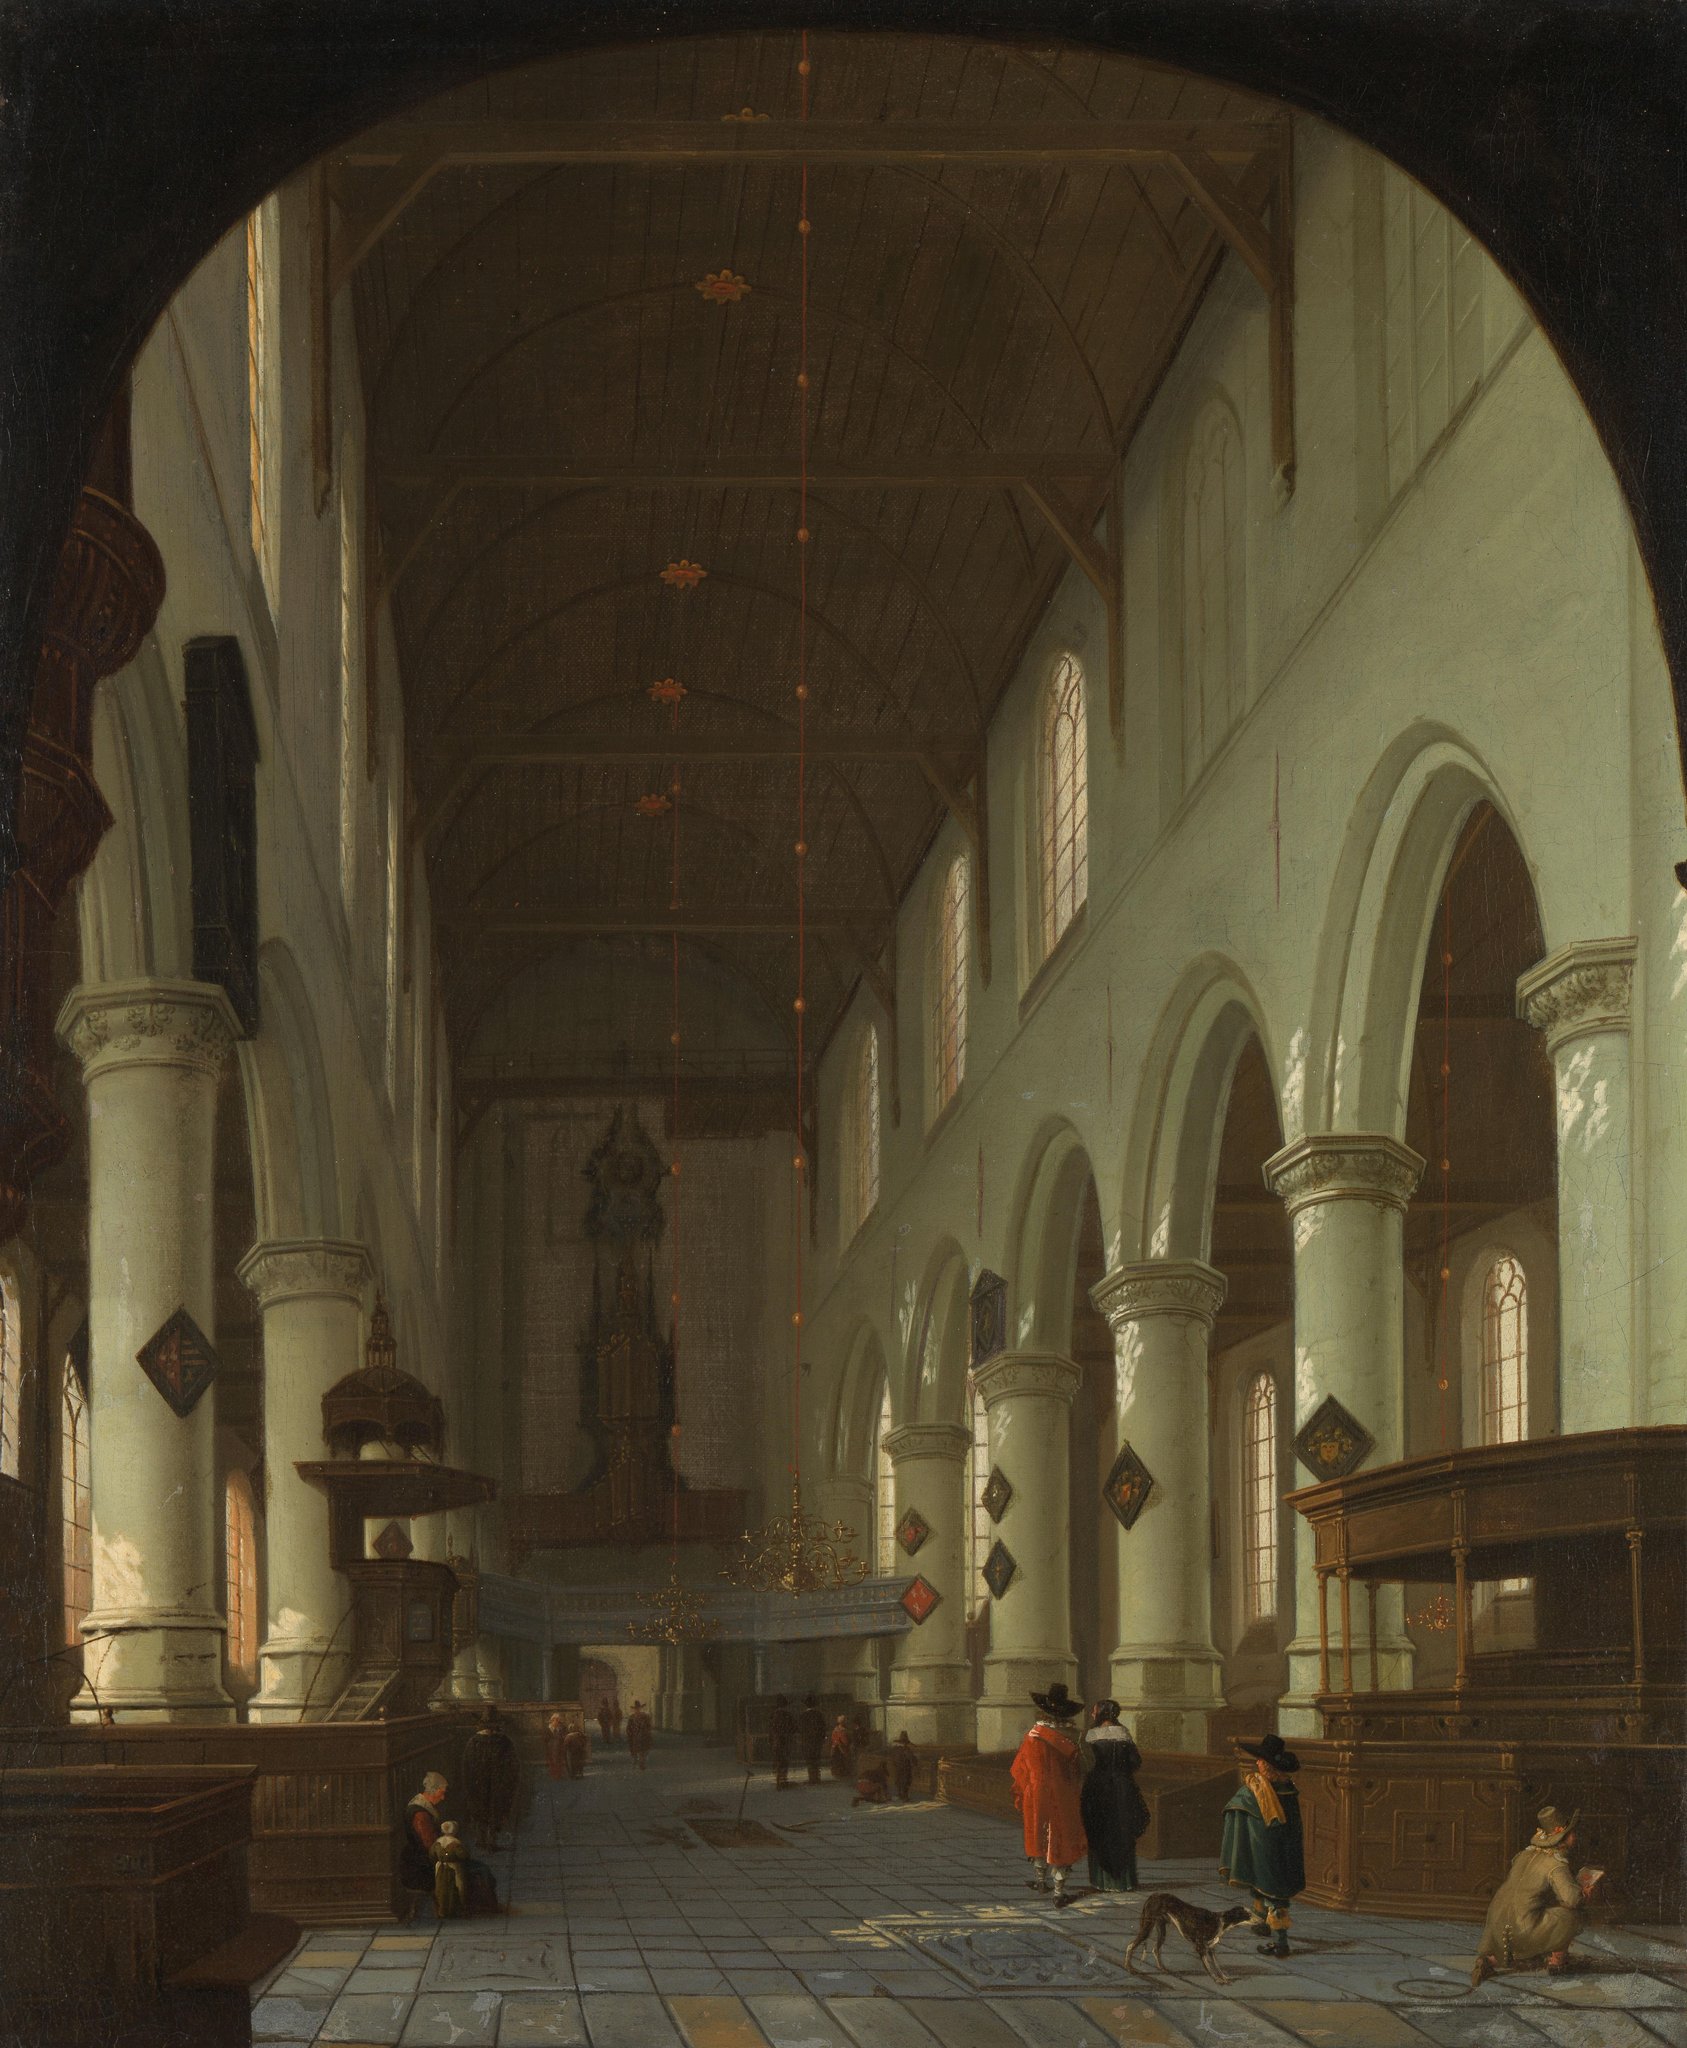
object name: painting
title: Interior of the Oude Kerk in Delft from the Choir toward the Portal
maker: cornelis de man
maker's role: painter, print maker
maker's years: 1621-1706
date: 1660-1690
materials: canvas, oil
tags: interior of church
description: Gezicht in de Oude Kerk te Delft vanuit het koor richting portaal.